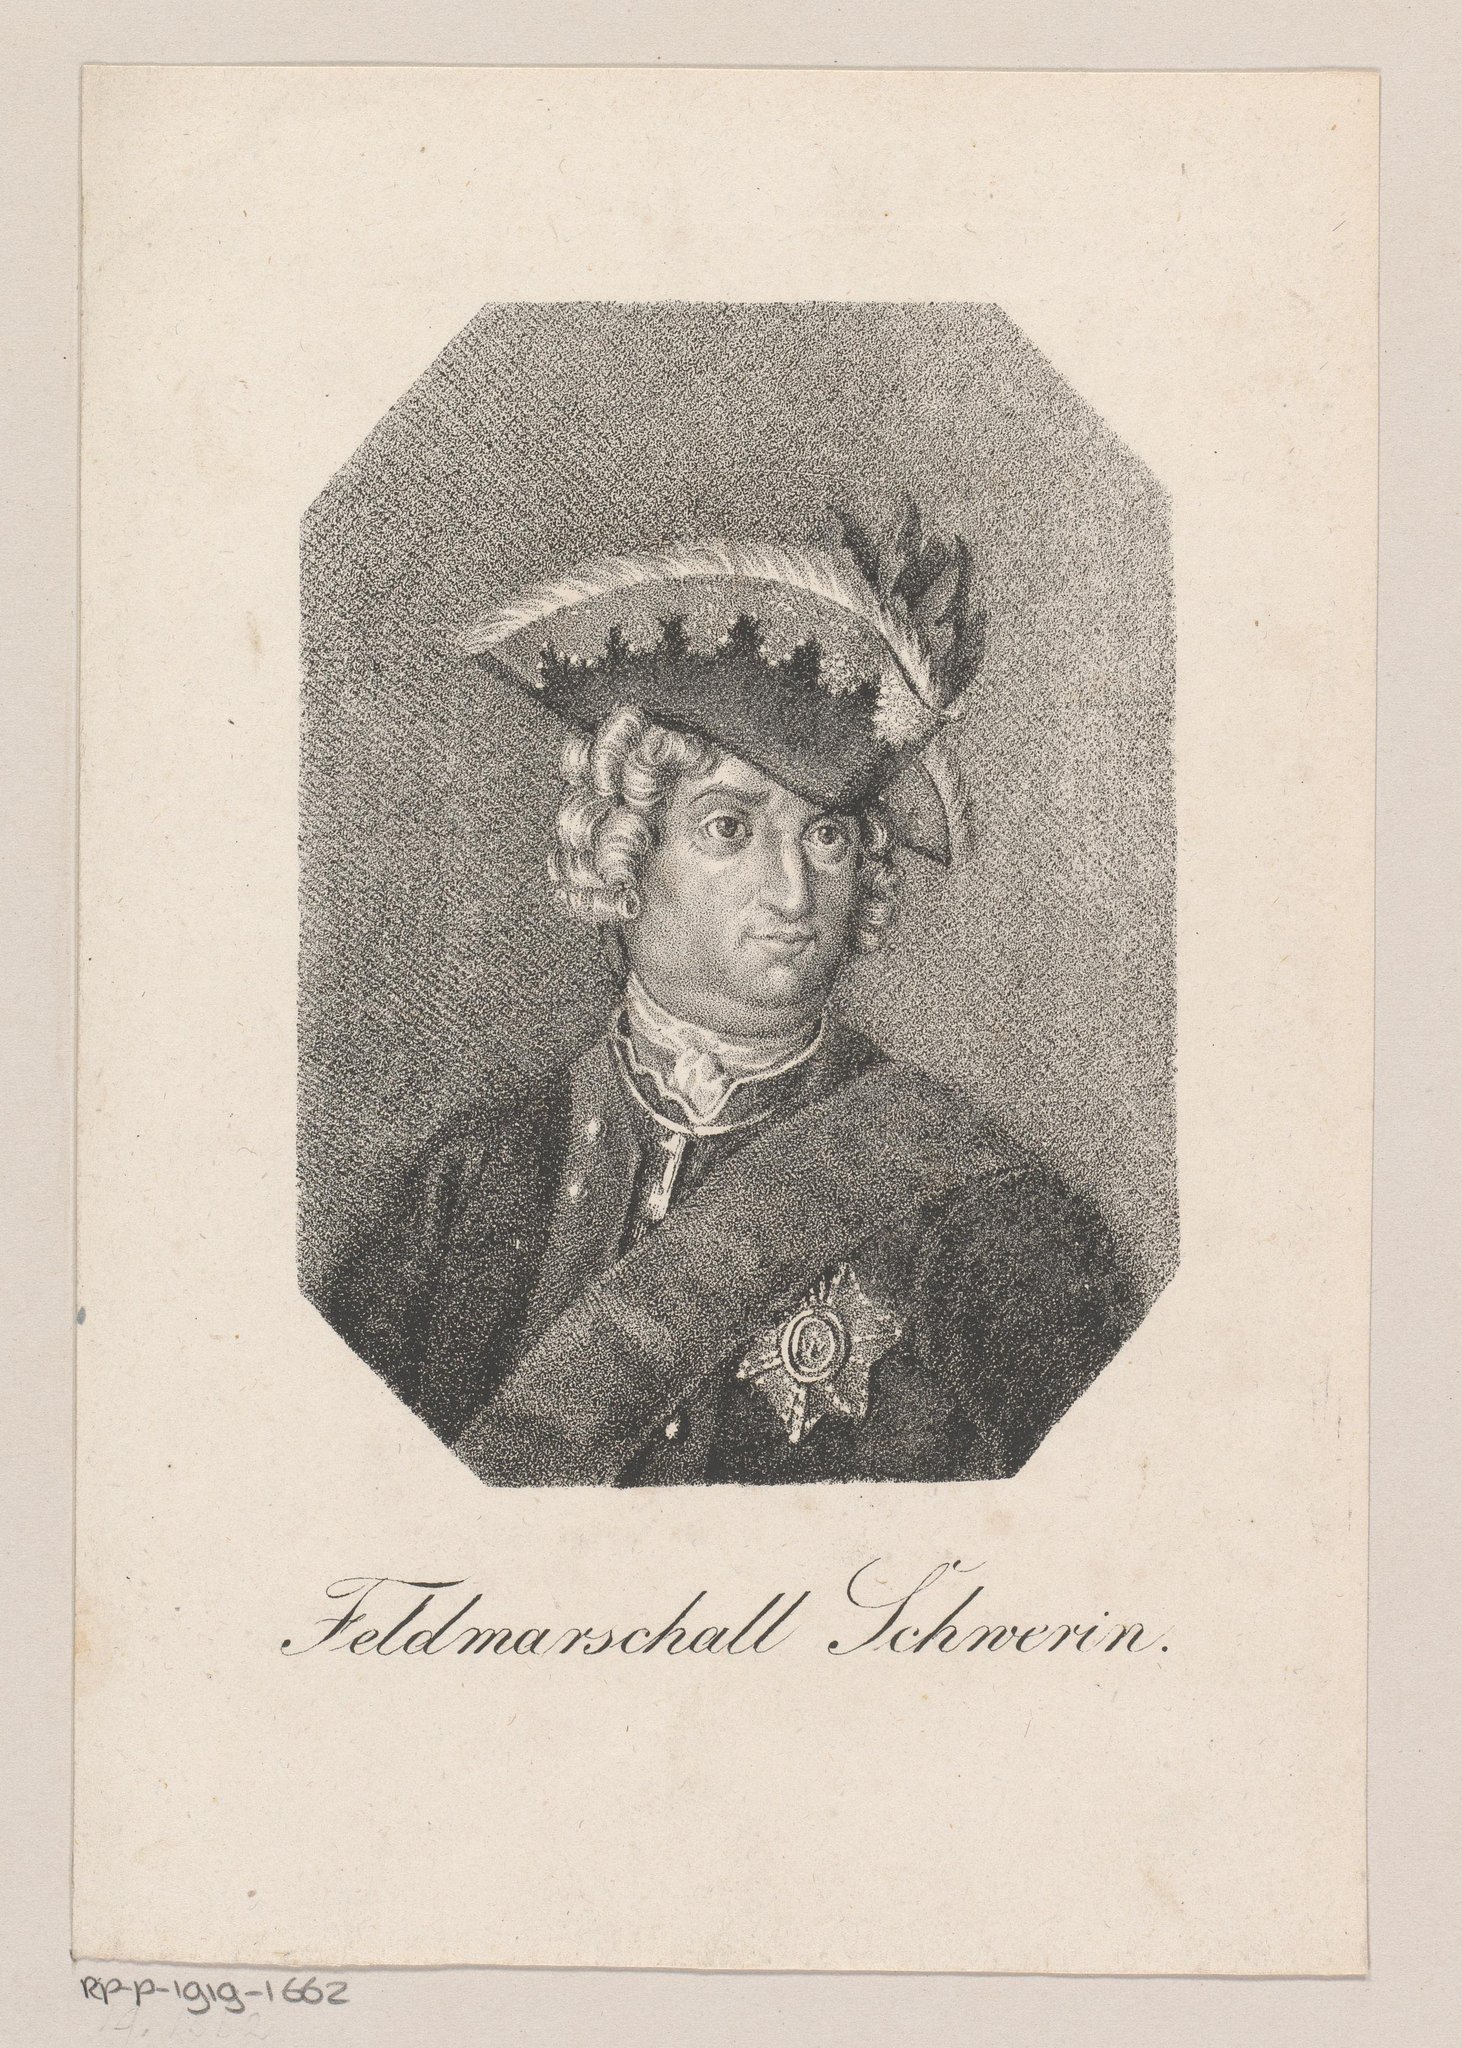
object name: print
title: Portret van Kurd Christoph von Schwerin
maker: Anonymous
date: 1798-1850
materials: paper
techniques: lithograph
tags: commander-in-chief, general, marshal, historical persons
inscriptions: collector's mark: Lugt 2228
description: Met eenregelig onderschrift in het Duits.